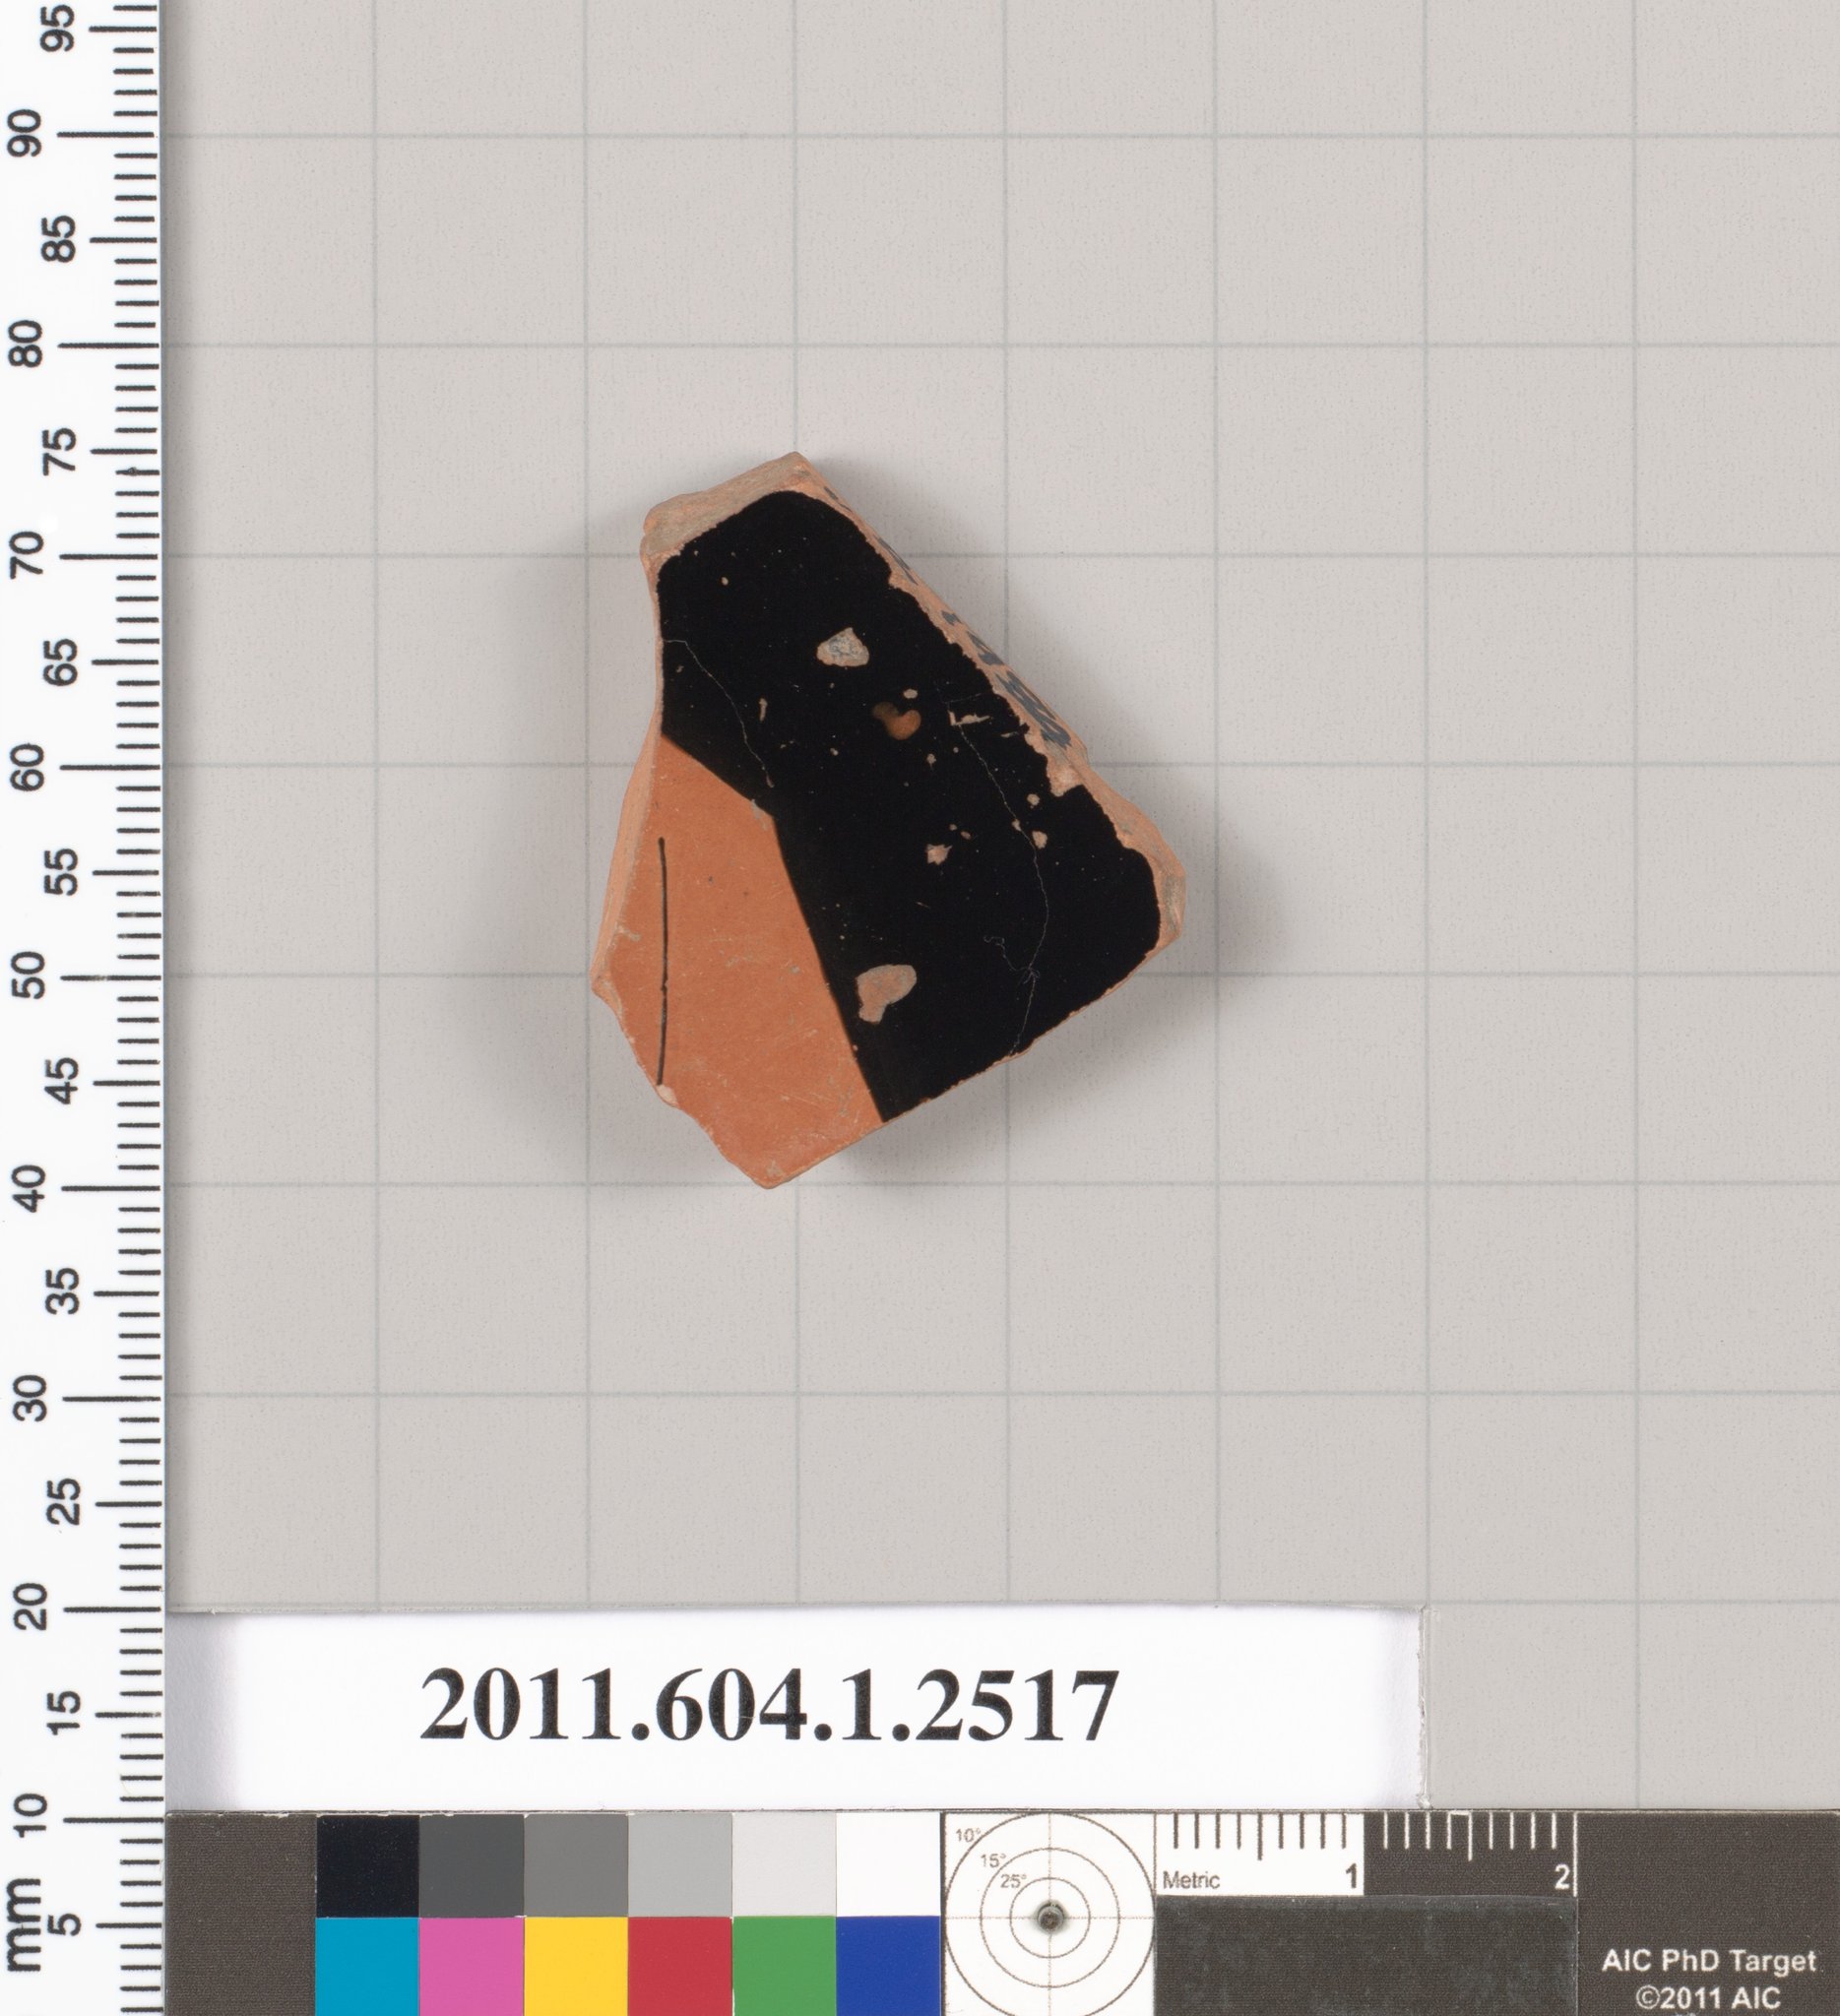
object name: kylix fragment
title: Terracotta fragment of a kylix (drinking cup)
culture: greek, attic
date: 475-451 BCE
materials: terracotta